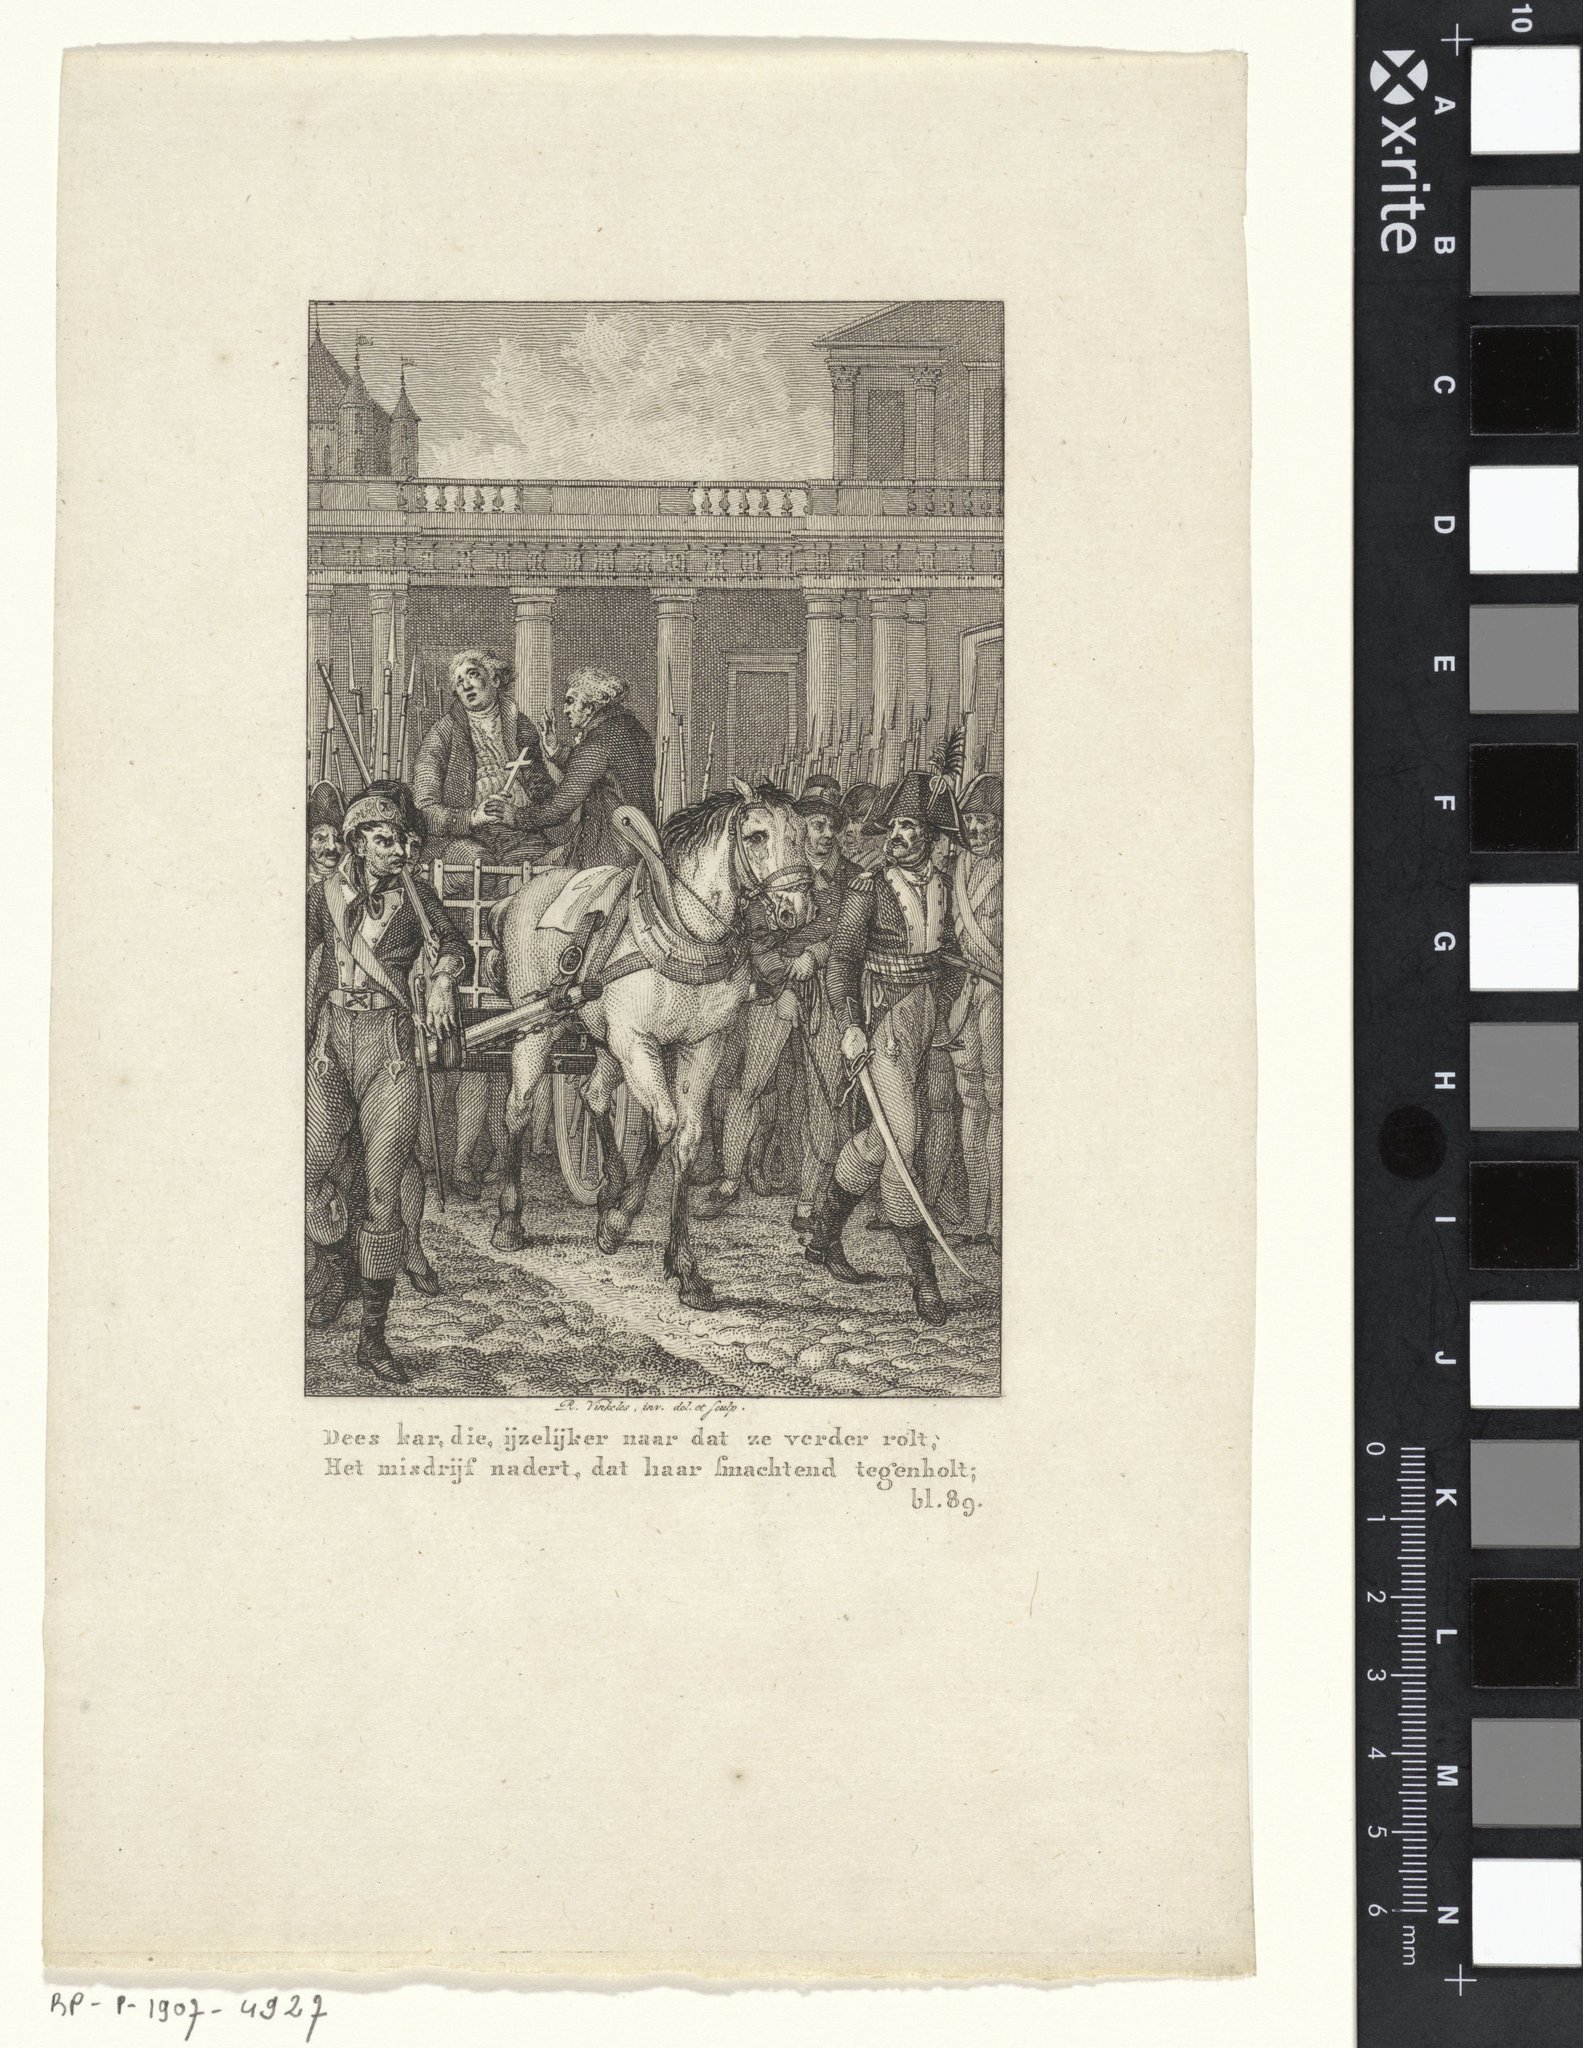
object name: print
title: Man met een kruis in de hand op een wagen omringd door soldaten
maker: reinier vinkeles (i)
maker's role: draughtsman, print maker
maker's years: 1741-1816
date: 1751-1816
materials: paper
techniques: engraving, etching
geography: amsterdam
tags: cross as symbol of christ, the soldier; the soldier's life, two-wheeled vehicle drawn by one animal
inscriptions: collector's mark: Lugt 2228